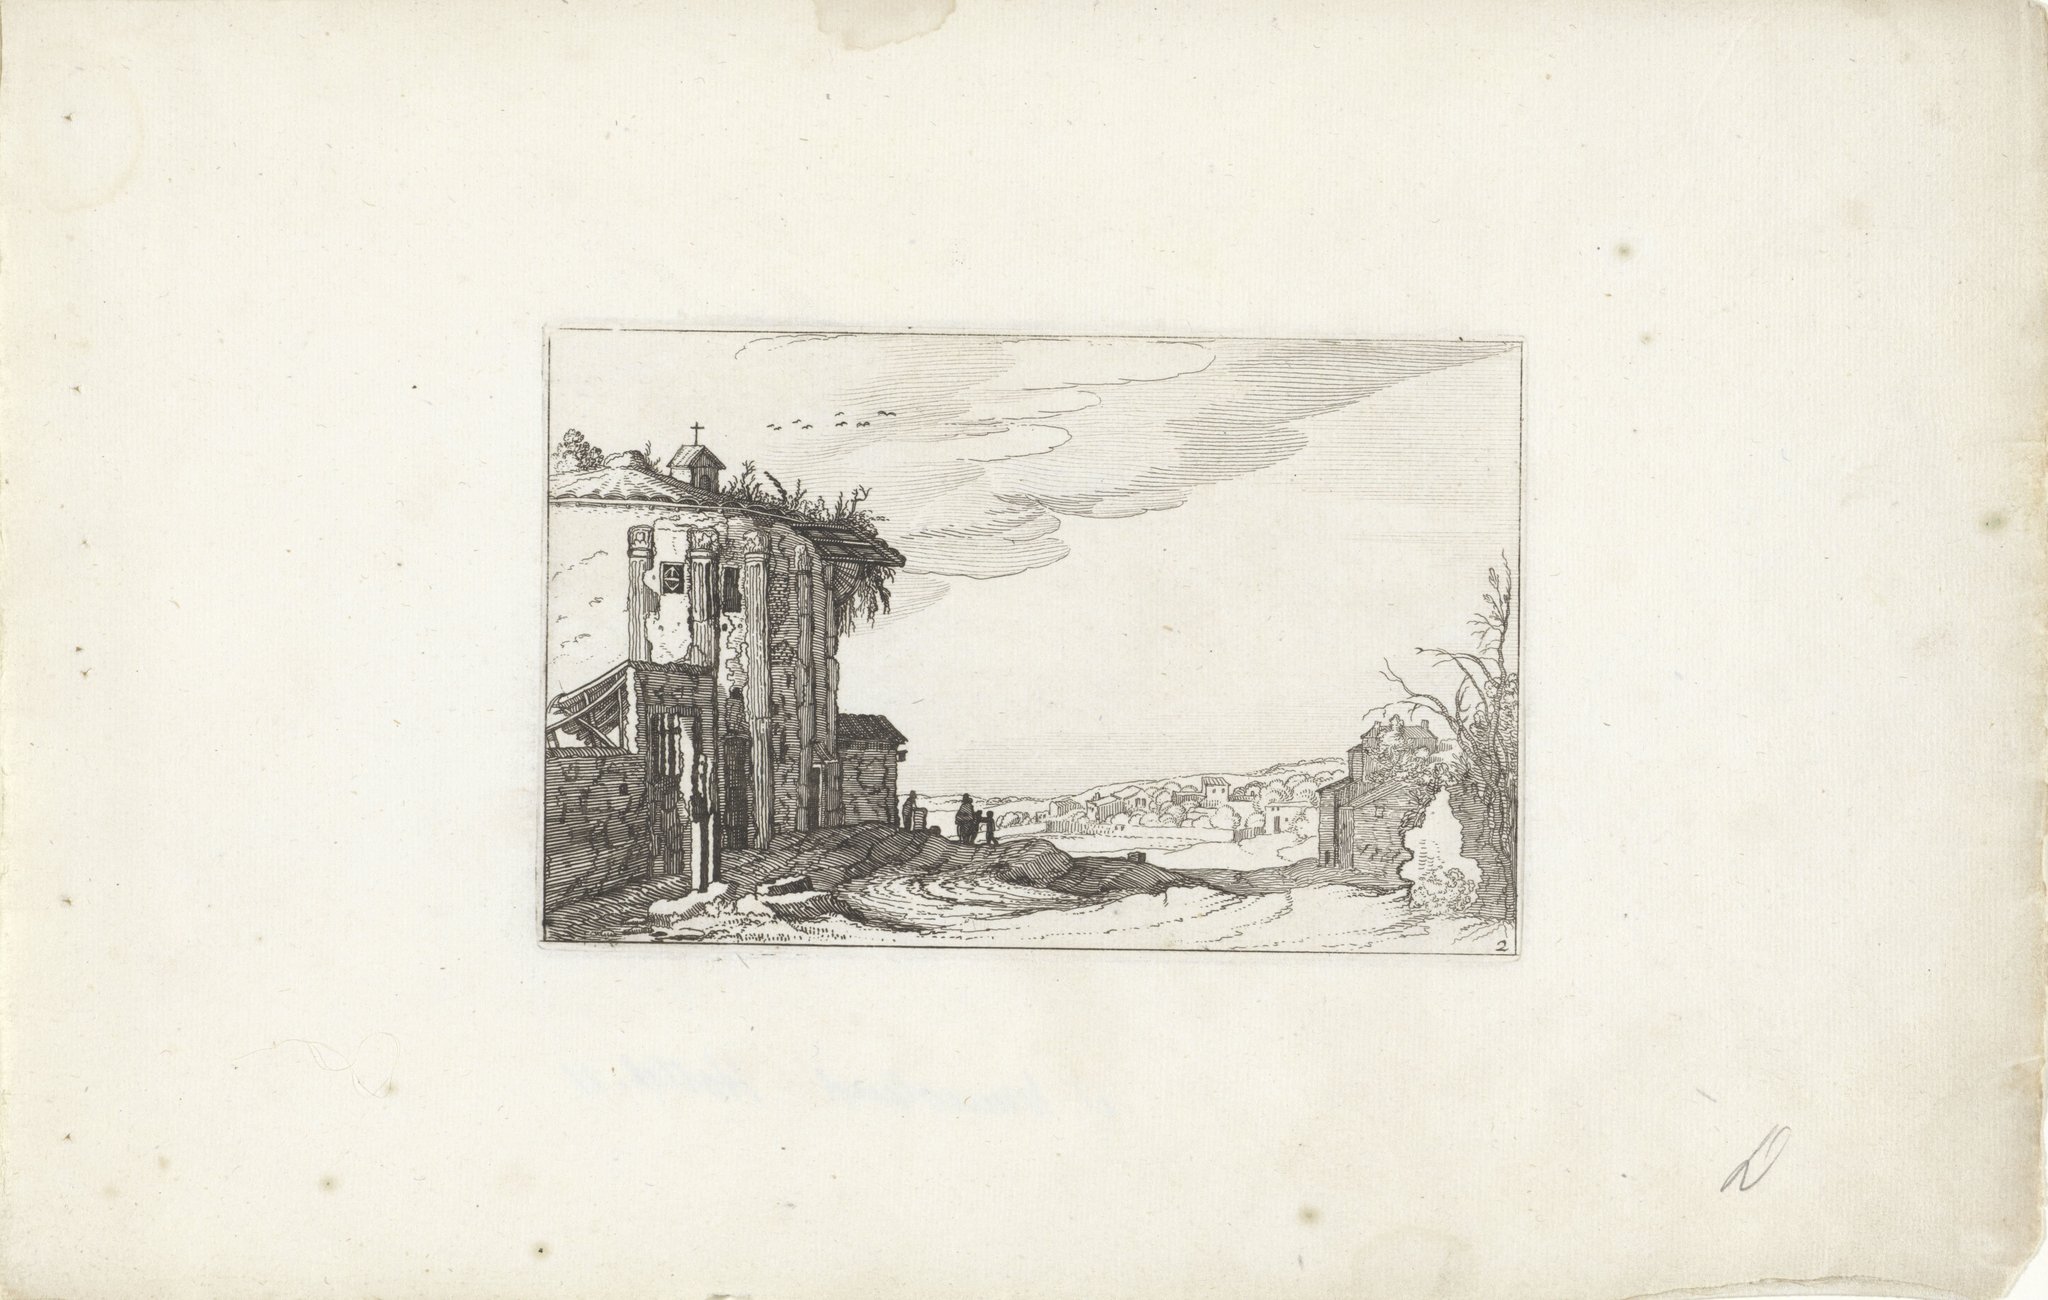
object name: print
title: Tempel van Fortuna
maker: claes jansz. visscher (ii)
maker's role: draughtsman, print maker, publisher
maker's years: 1586-1652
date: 1618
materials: paper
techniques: etching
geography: amsterdam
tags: prospect of city, town panorama, silhouette of city - ii - ideal city, landscapes, temple, shrine ~ greek religion, rome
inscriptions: collector's mark: Lugt 2233, number: ‘2’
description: Gezicht op een landweg met de tempel van Fortuna, gelegen naast de Santa Maria in Cosmedin te Rome. Op de voorgrond een groepje figuren. Op de achtergrond de contouren van de stad.